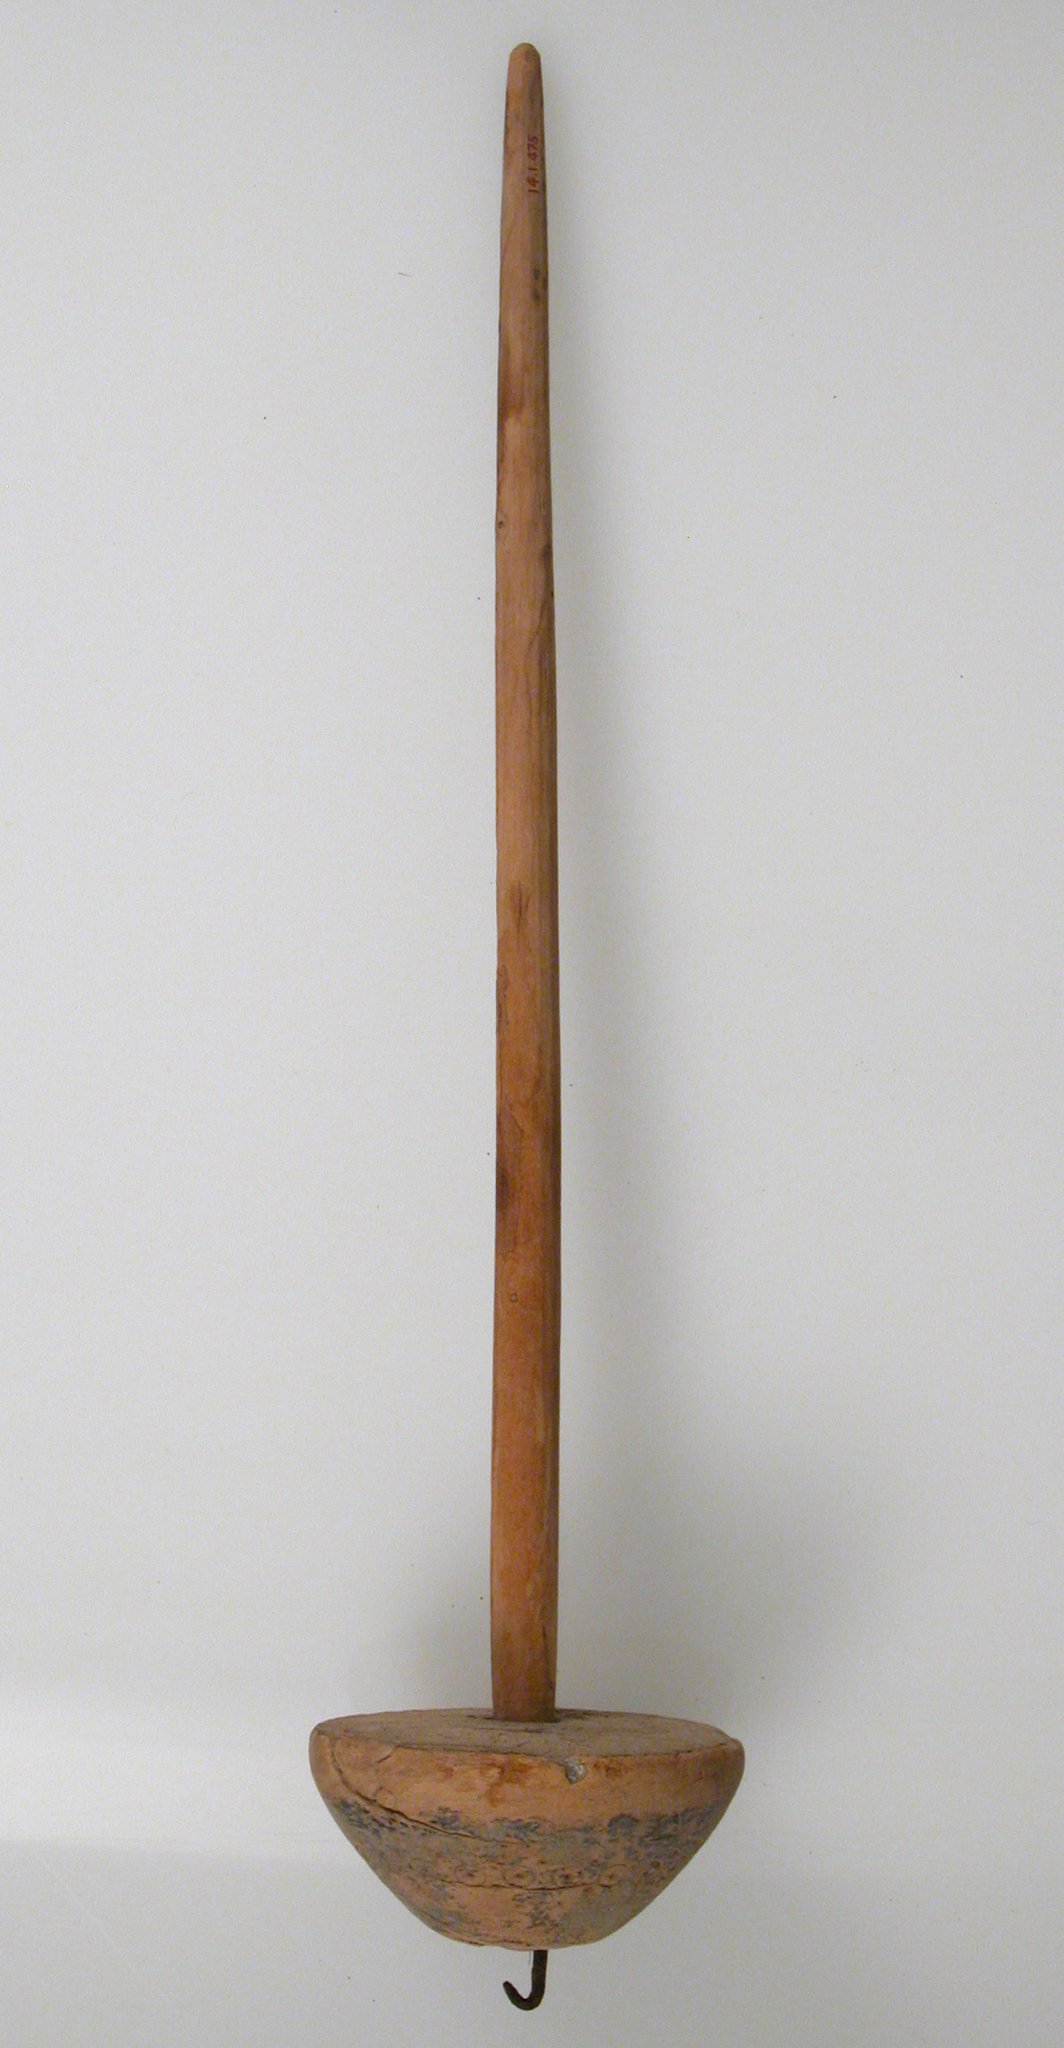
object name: spindle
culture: coptic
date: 580-640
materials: iron, wood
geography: egypt